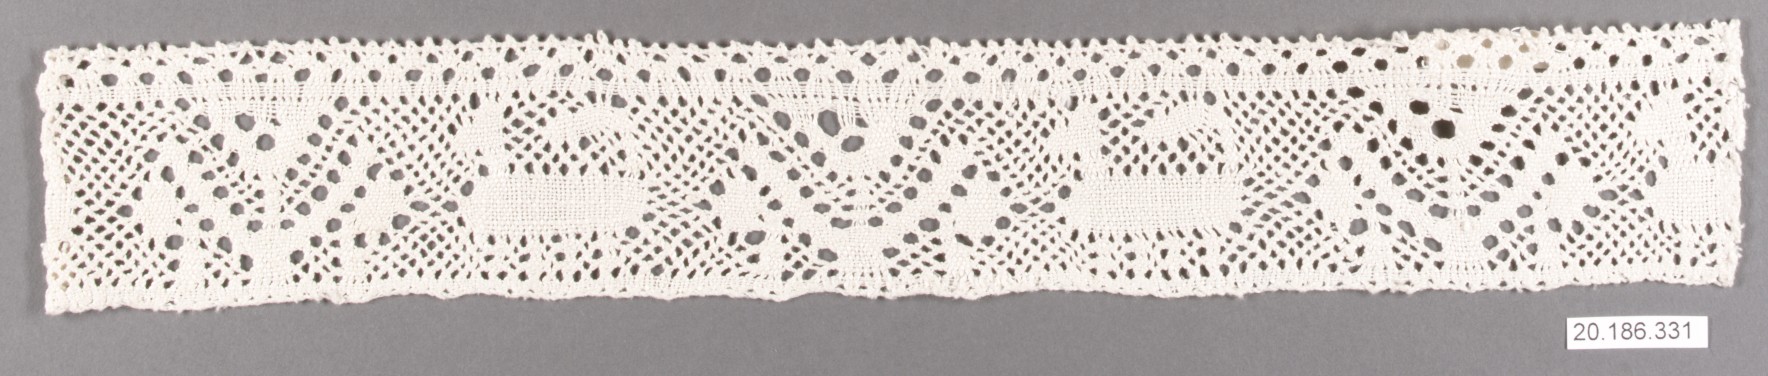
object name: edging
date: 1701-1800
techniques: lace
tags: animals